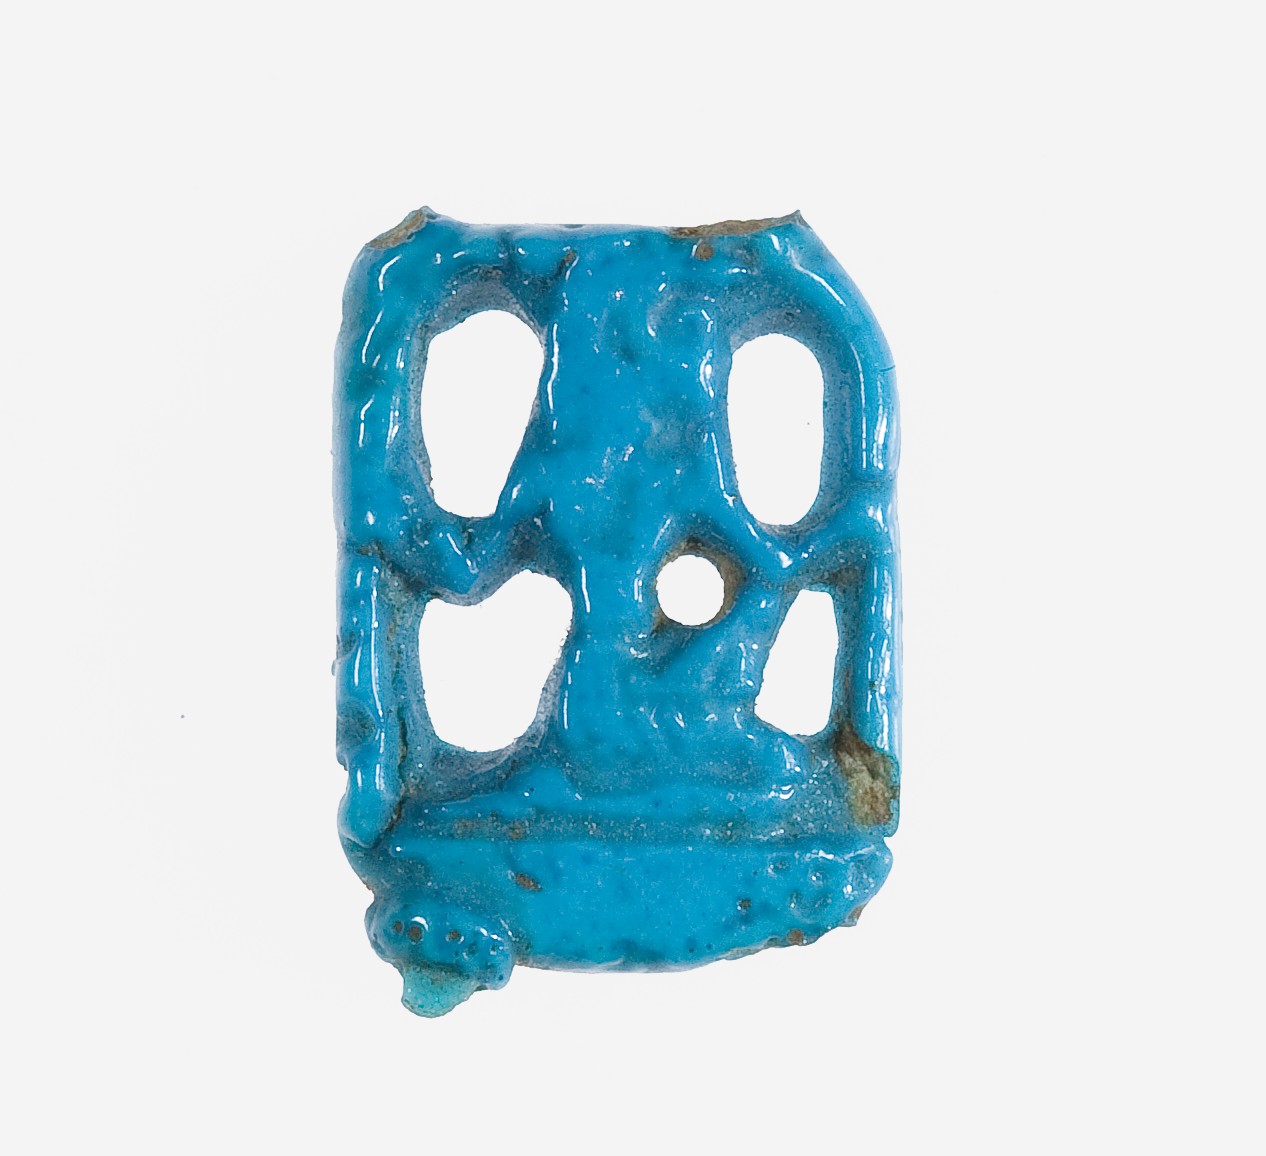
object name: amulet, heh eternity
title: Eternity Amulet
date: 1390-1352 BCE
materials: faience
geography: egypt